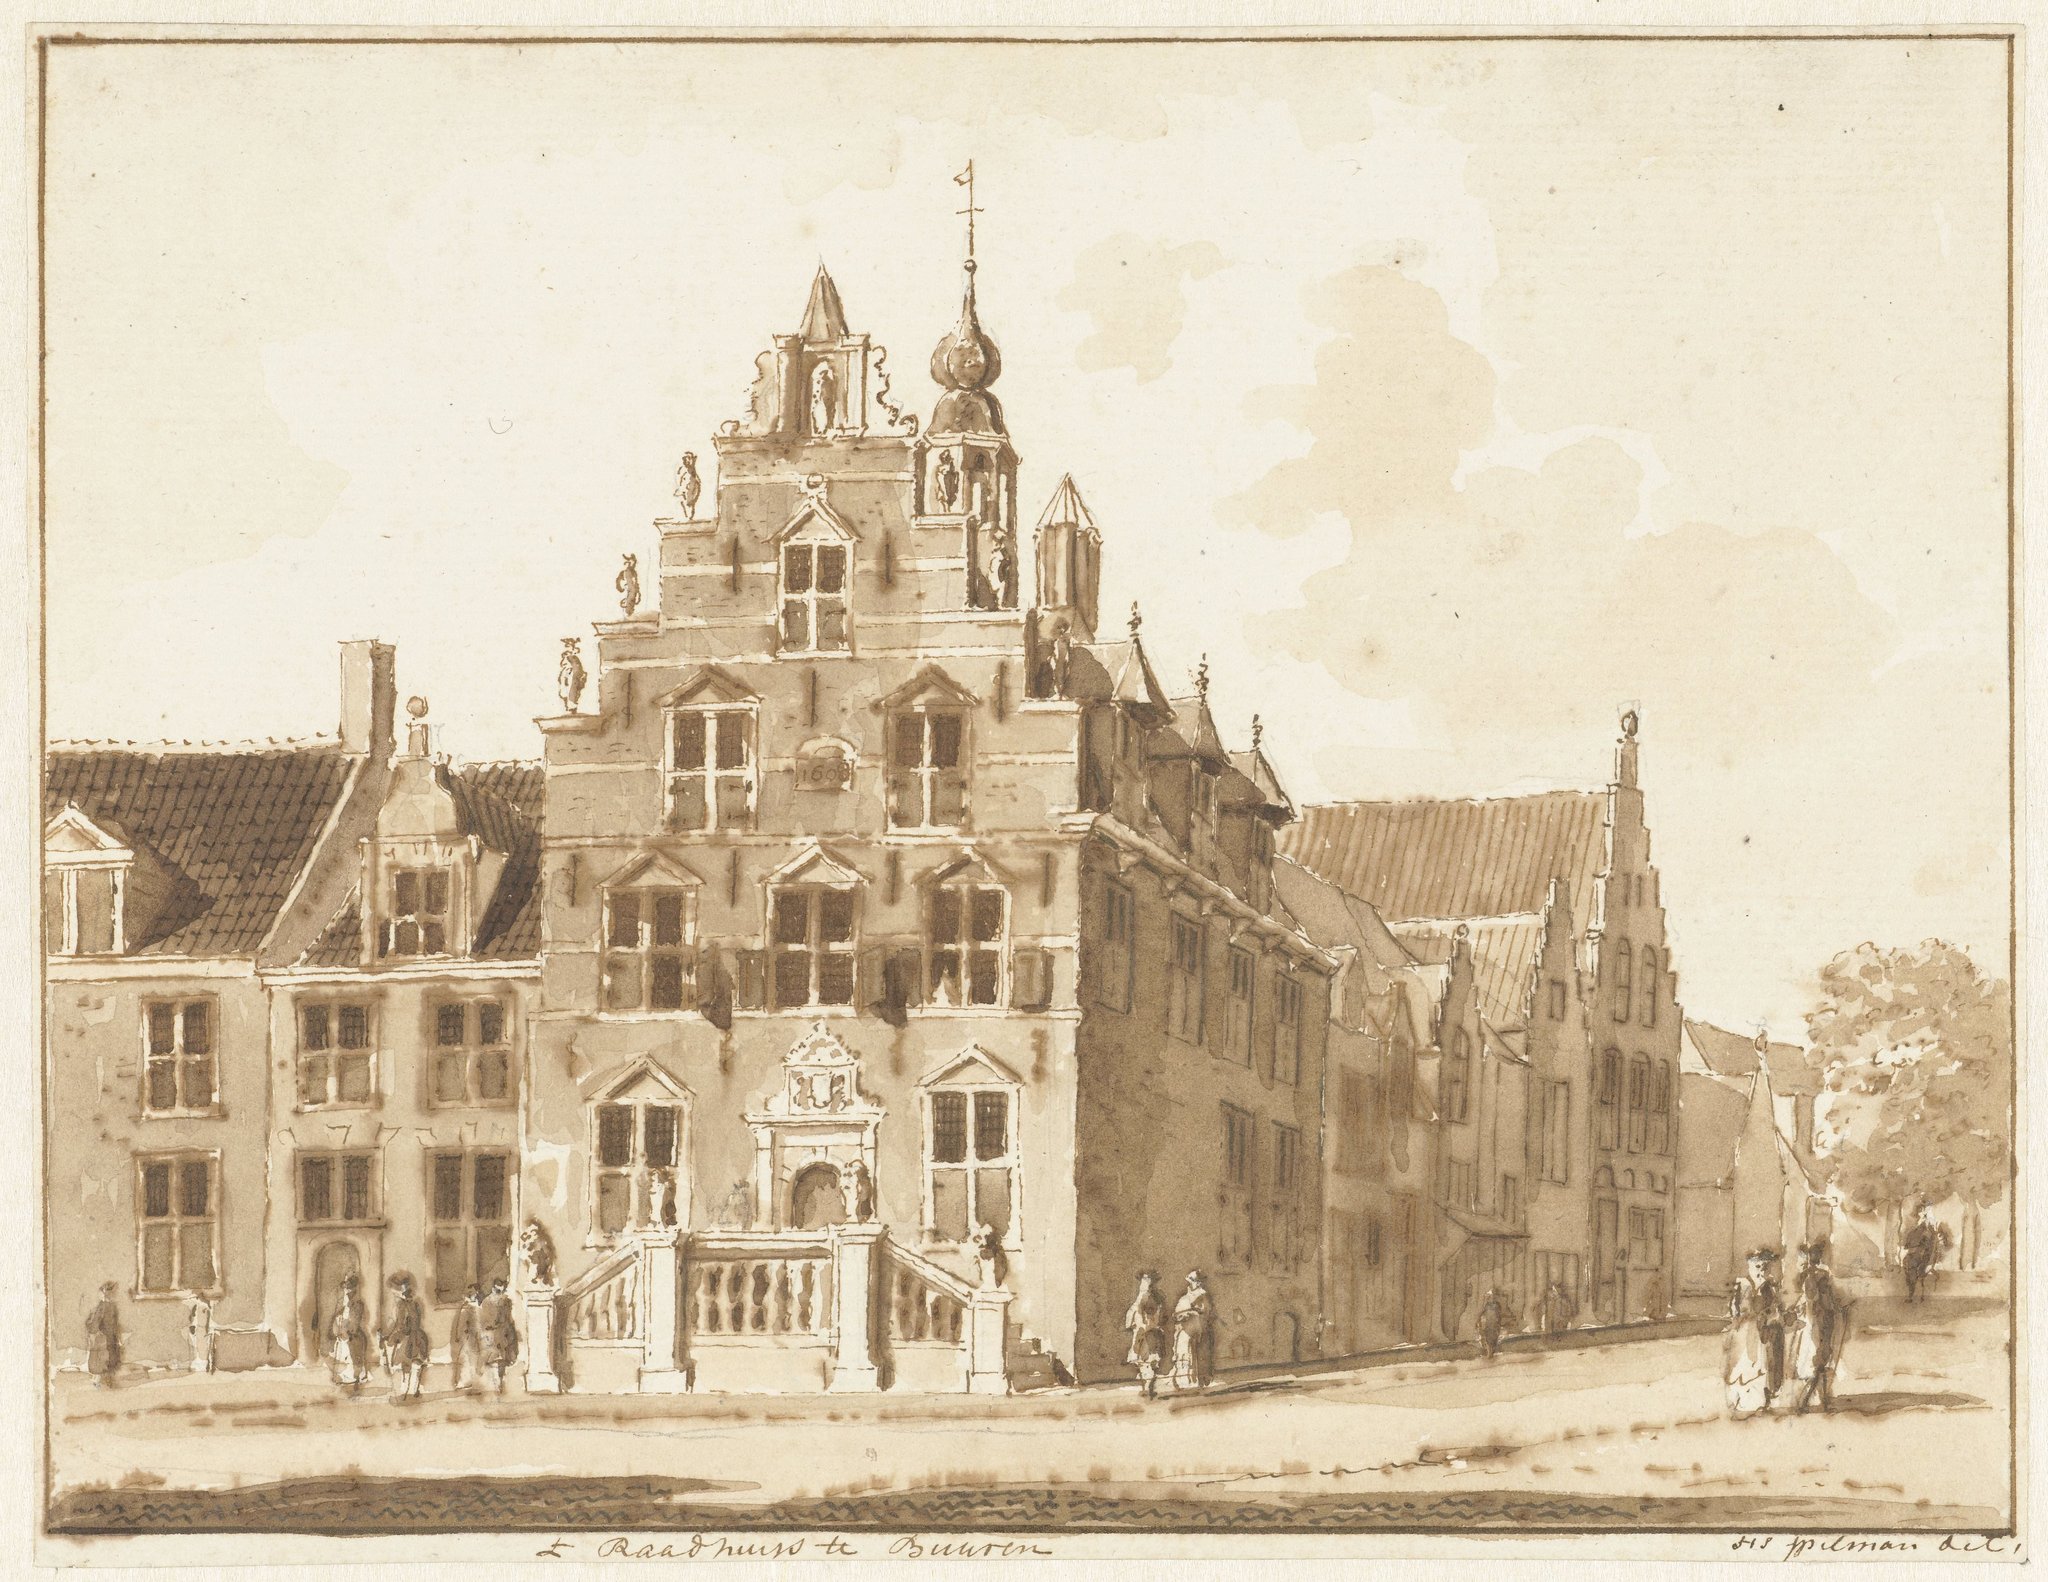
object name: drawing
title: Het stadhuis van Buren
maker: hendrik spilman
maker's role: draughtsman, painter, print maker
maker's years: 1721-1784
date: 1757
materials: ink, paper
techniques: brush, pen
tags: townhall, buren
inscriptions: inscription: ‘Hs Spilman del / 't Raadhuys te Buuren’, inscription: ‘1757’